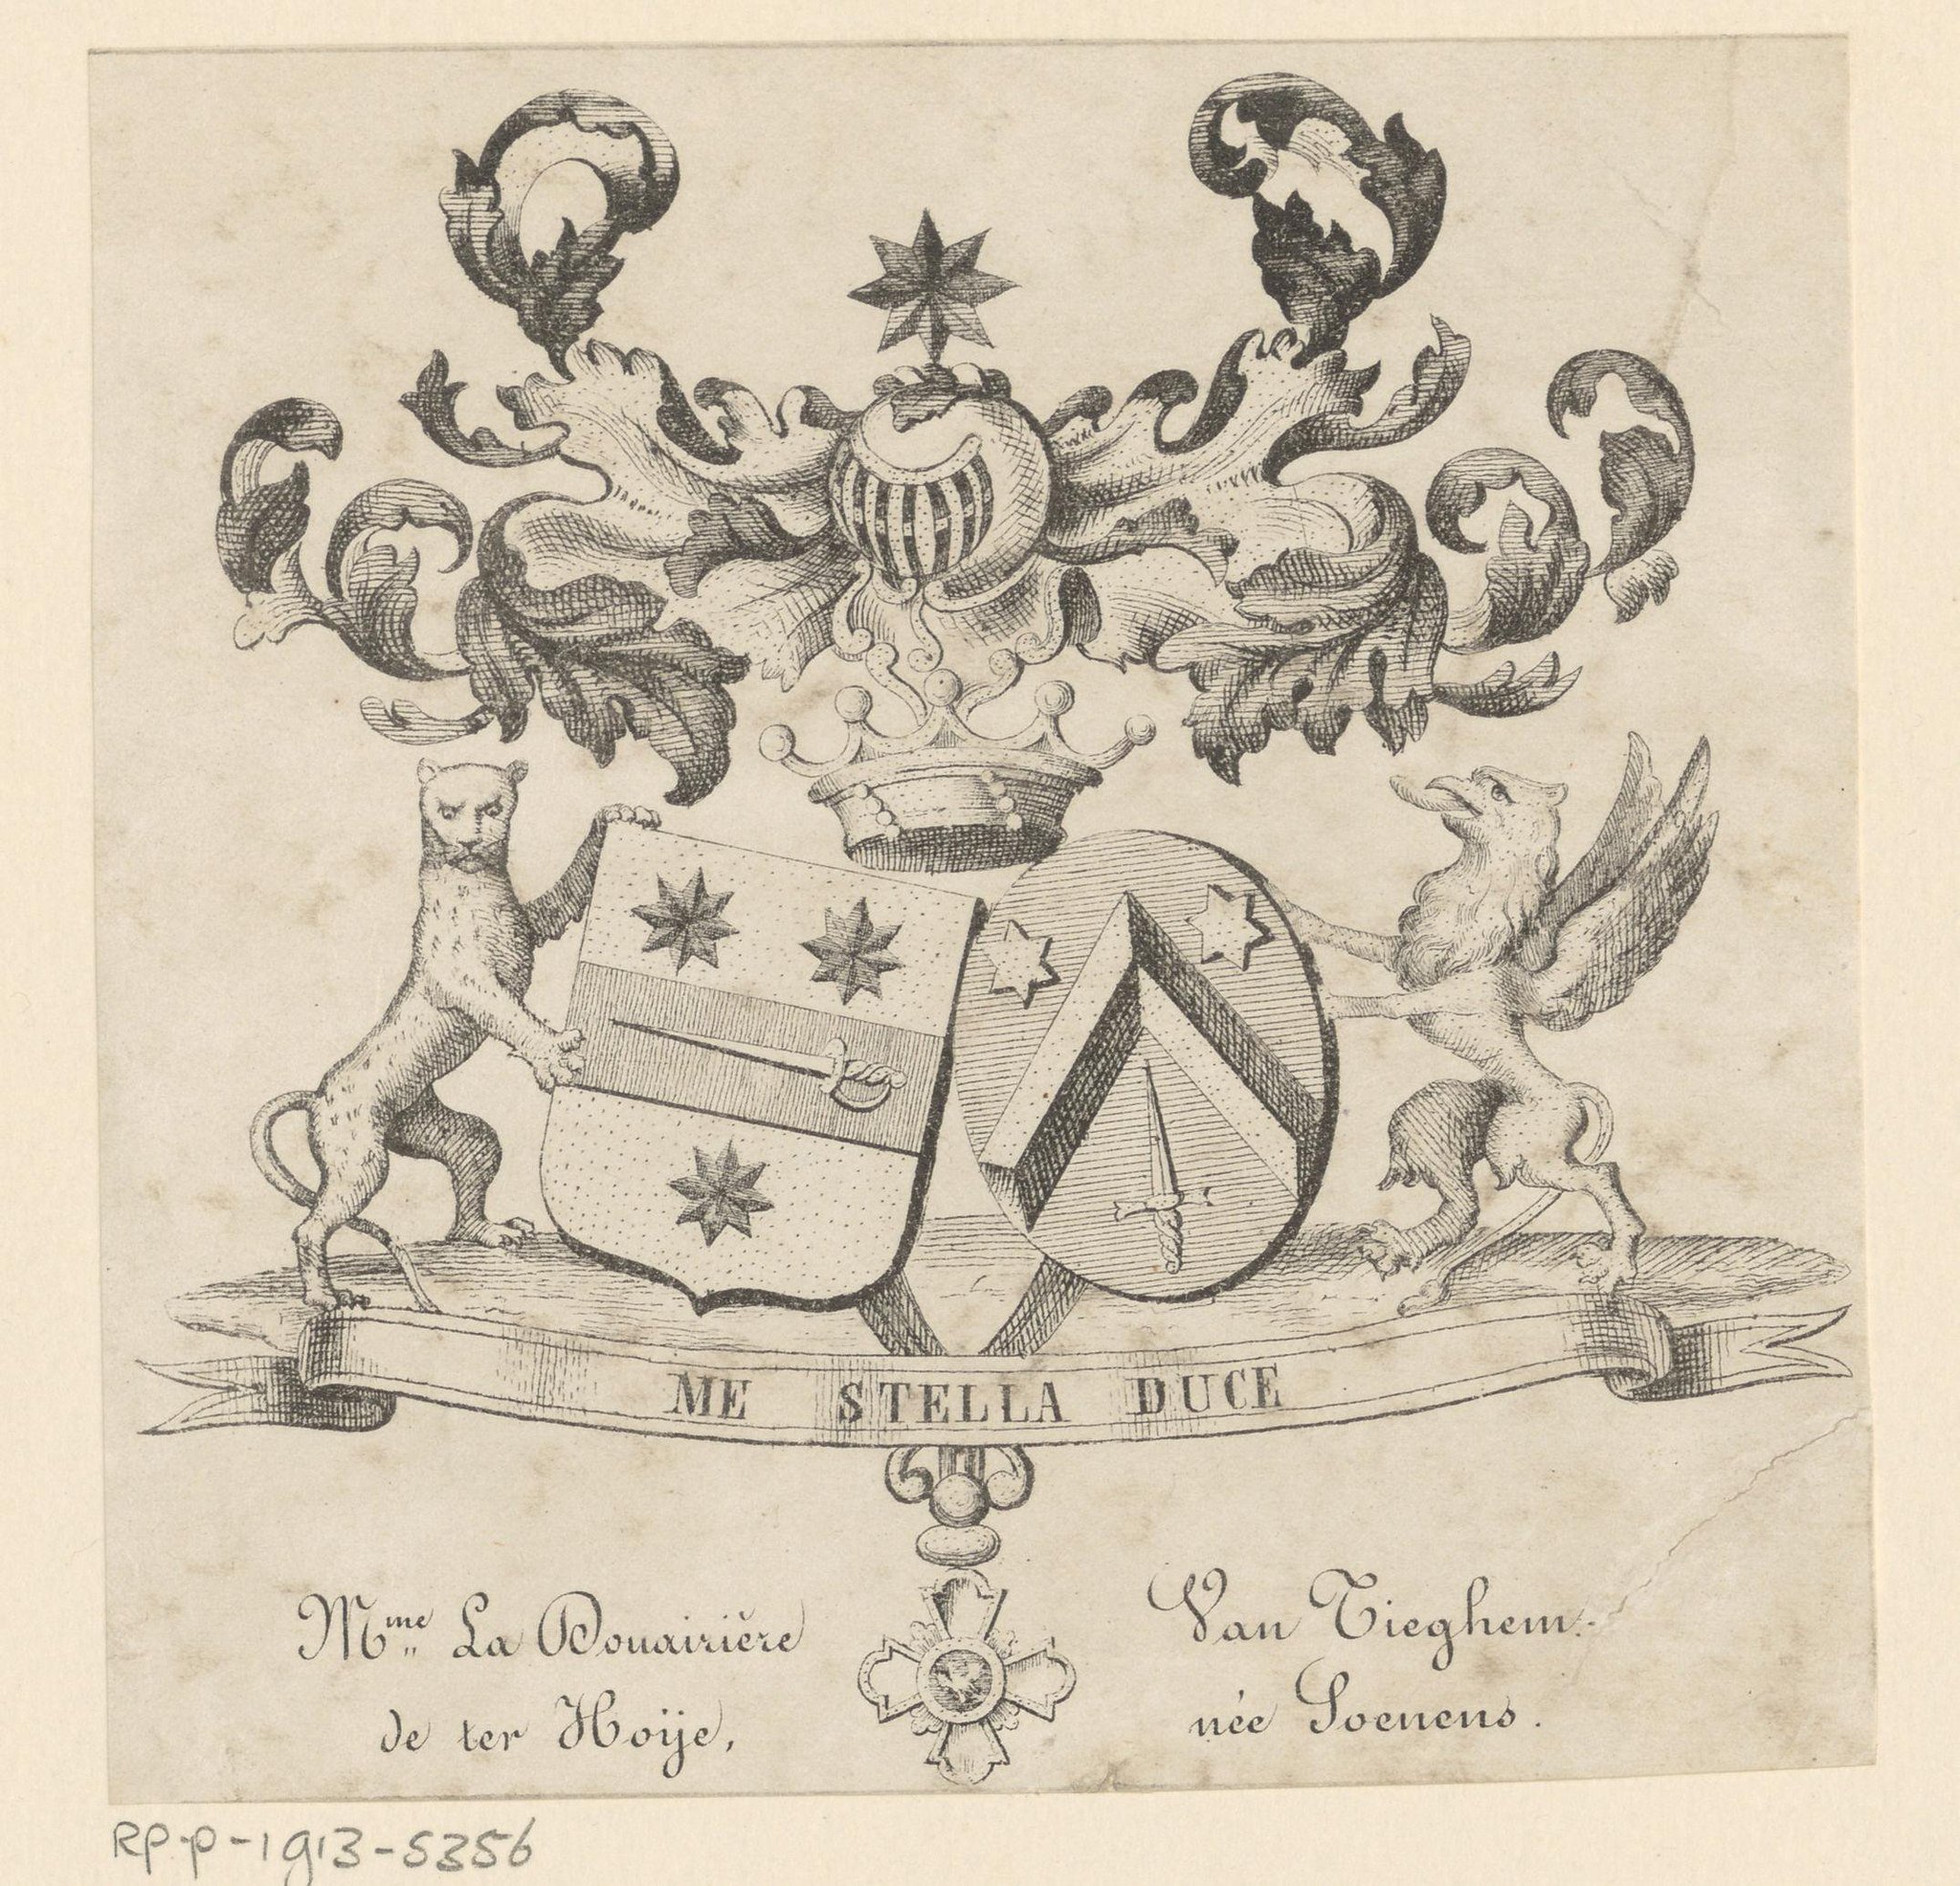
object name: bookplate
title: Me stella duce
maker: Anonymous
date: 1800-1899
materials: paper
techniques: etching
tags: armorial bearing, heraldry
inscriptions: collector's mark: Lugt 2760, collector's mark: Lugt 2233